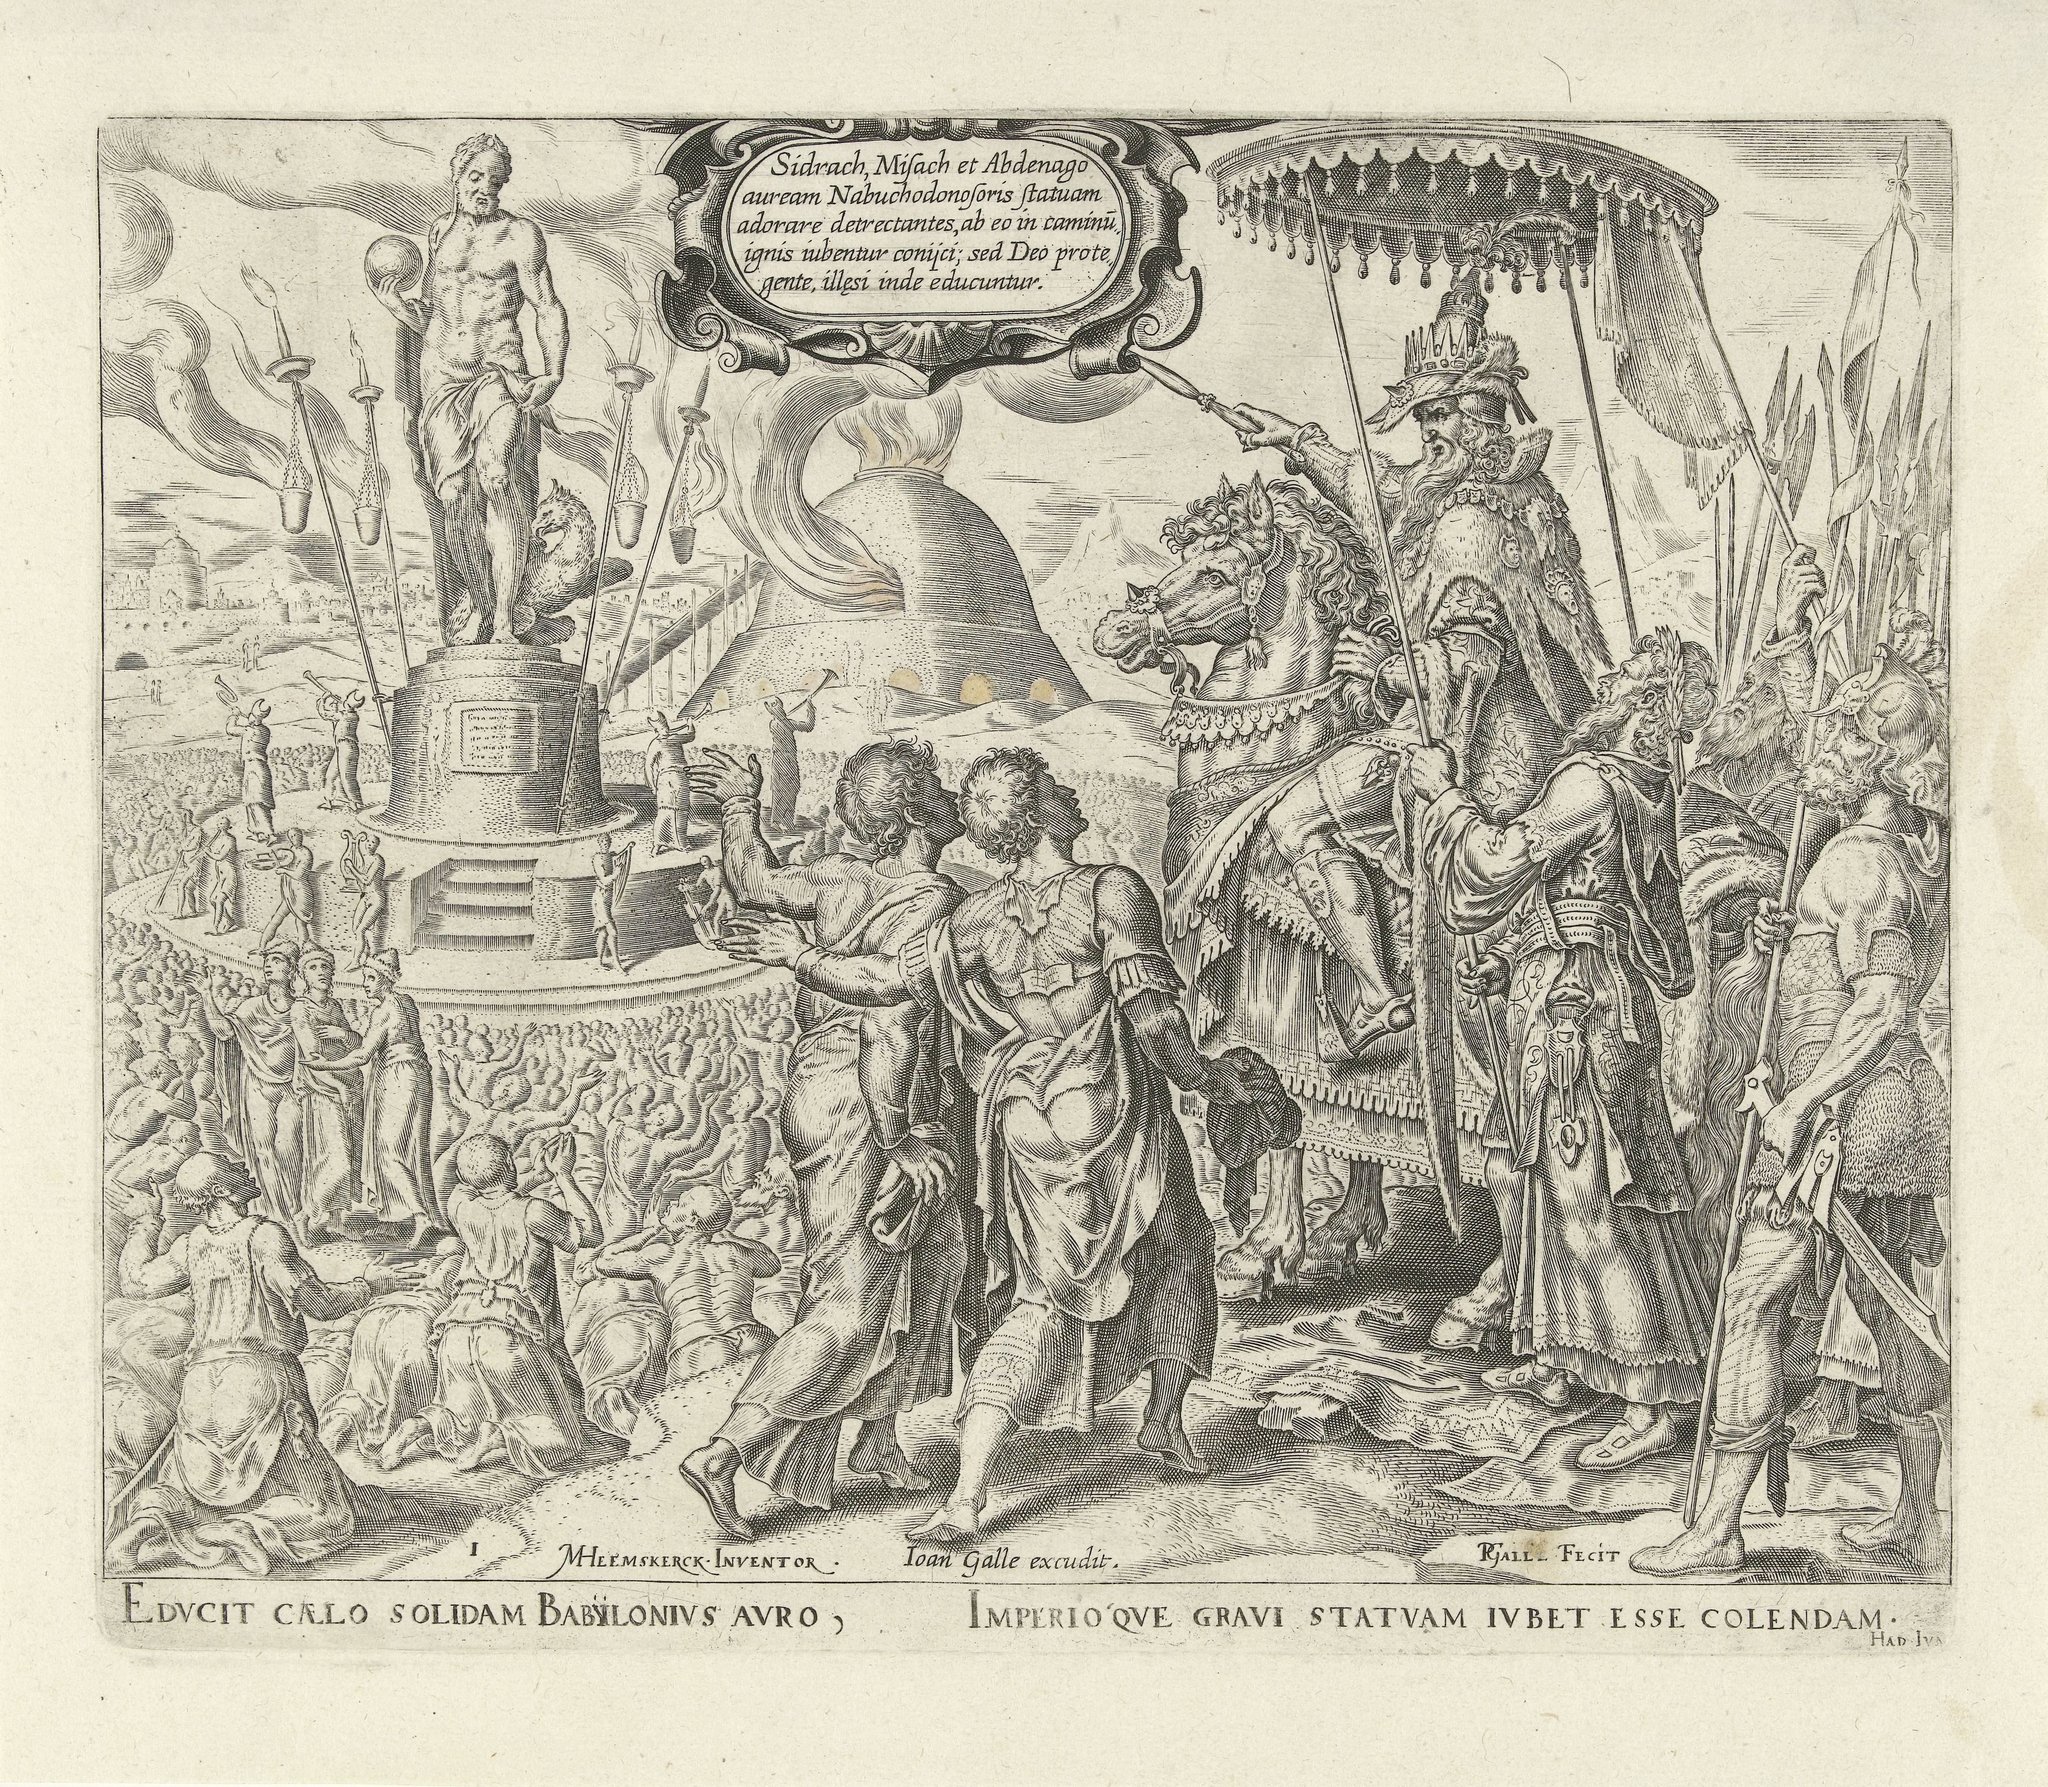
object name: print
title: Geschiedenis van Sadrach, Mesach en Abednego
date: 1627-1678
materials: paper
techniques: brush, engraving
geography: haarlem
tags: the dedication of the golden statue: in the presence of king nebuchadnezzar, trumpets are blown and all the people surrounding the image fall on their knees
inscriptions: collector's mark: Lugt 2228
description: Koning Nebukadnessar beschuldigt de Joden Sadrach, Mesach en Abednego ervan de heidense Goden niet te eren. Links een gouden standbeeld van een godheid en een mensenmassa die het beeld aanbidt. Op de achtergrond een brandende oven. Iedereen die weigert het beeld te aanbidden wordt in de oven gegooid.